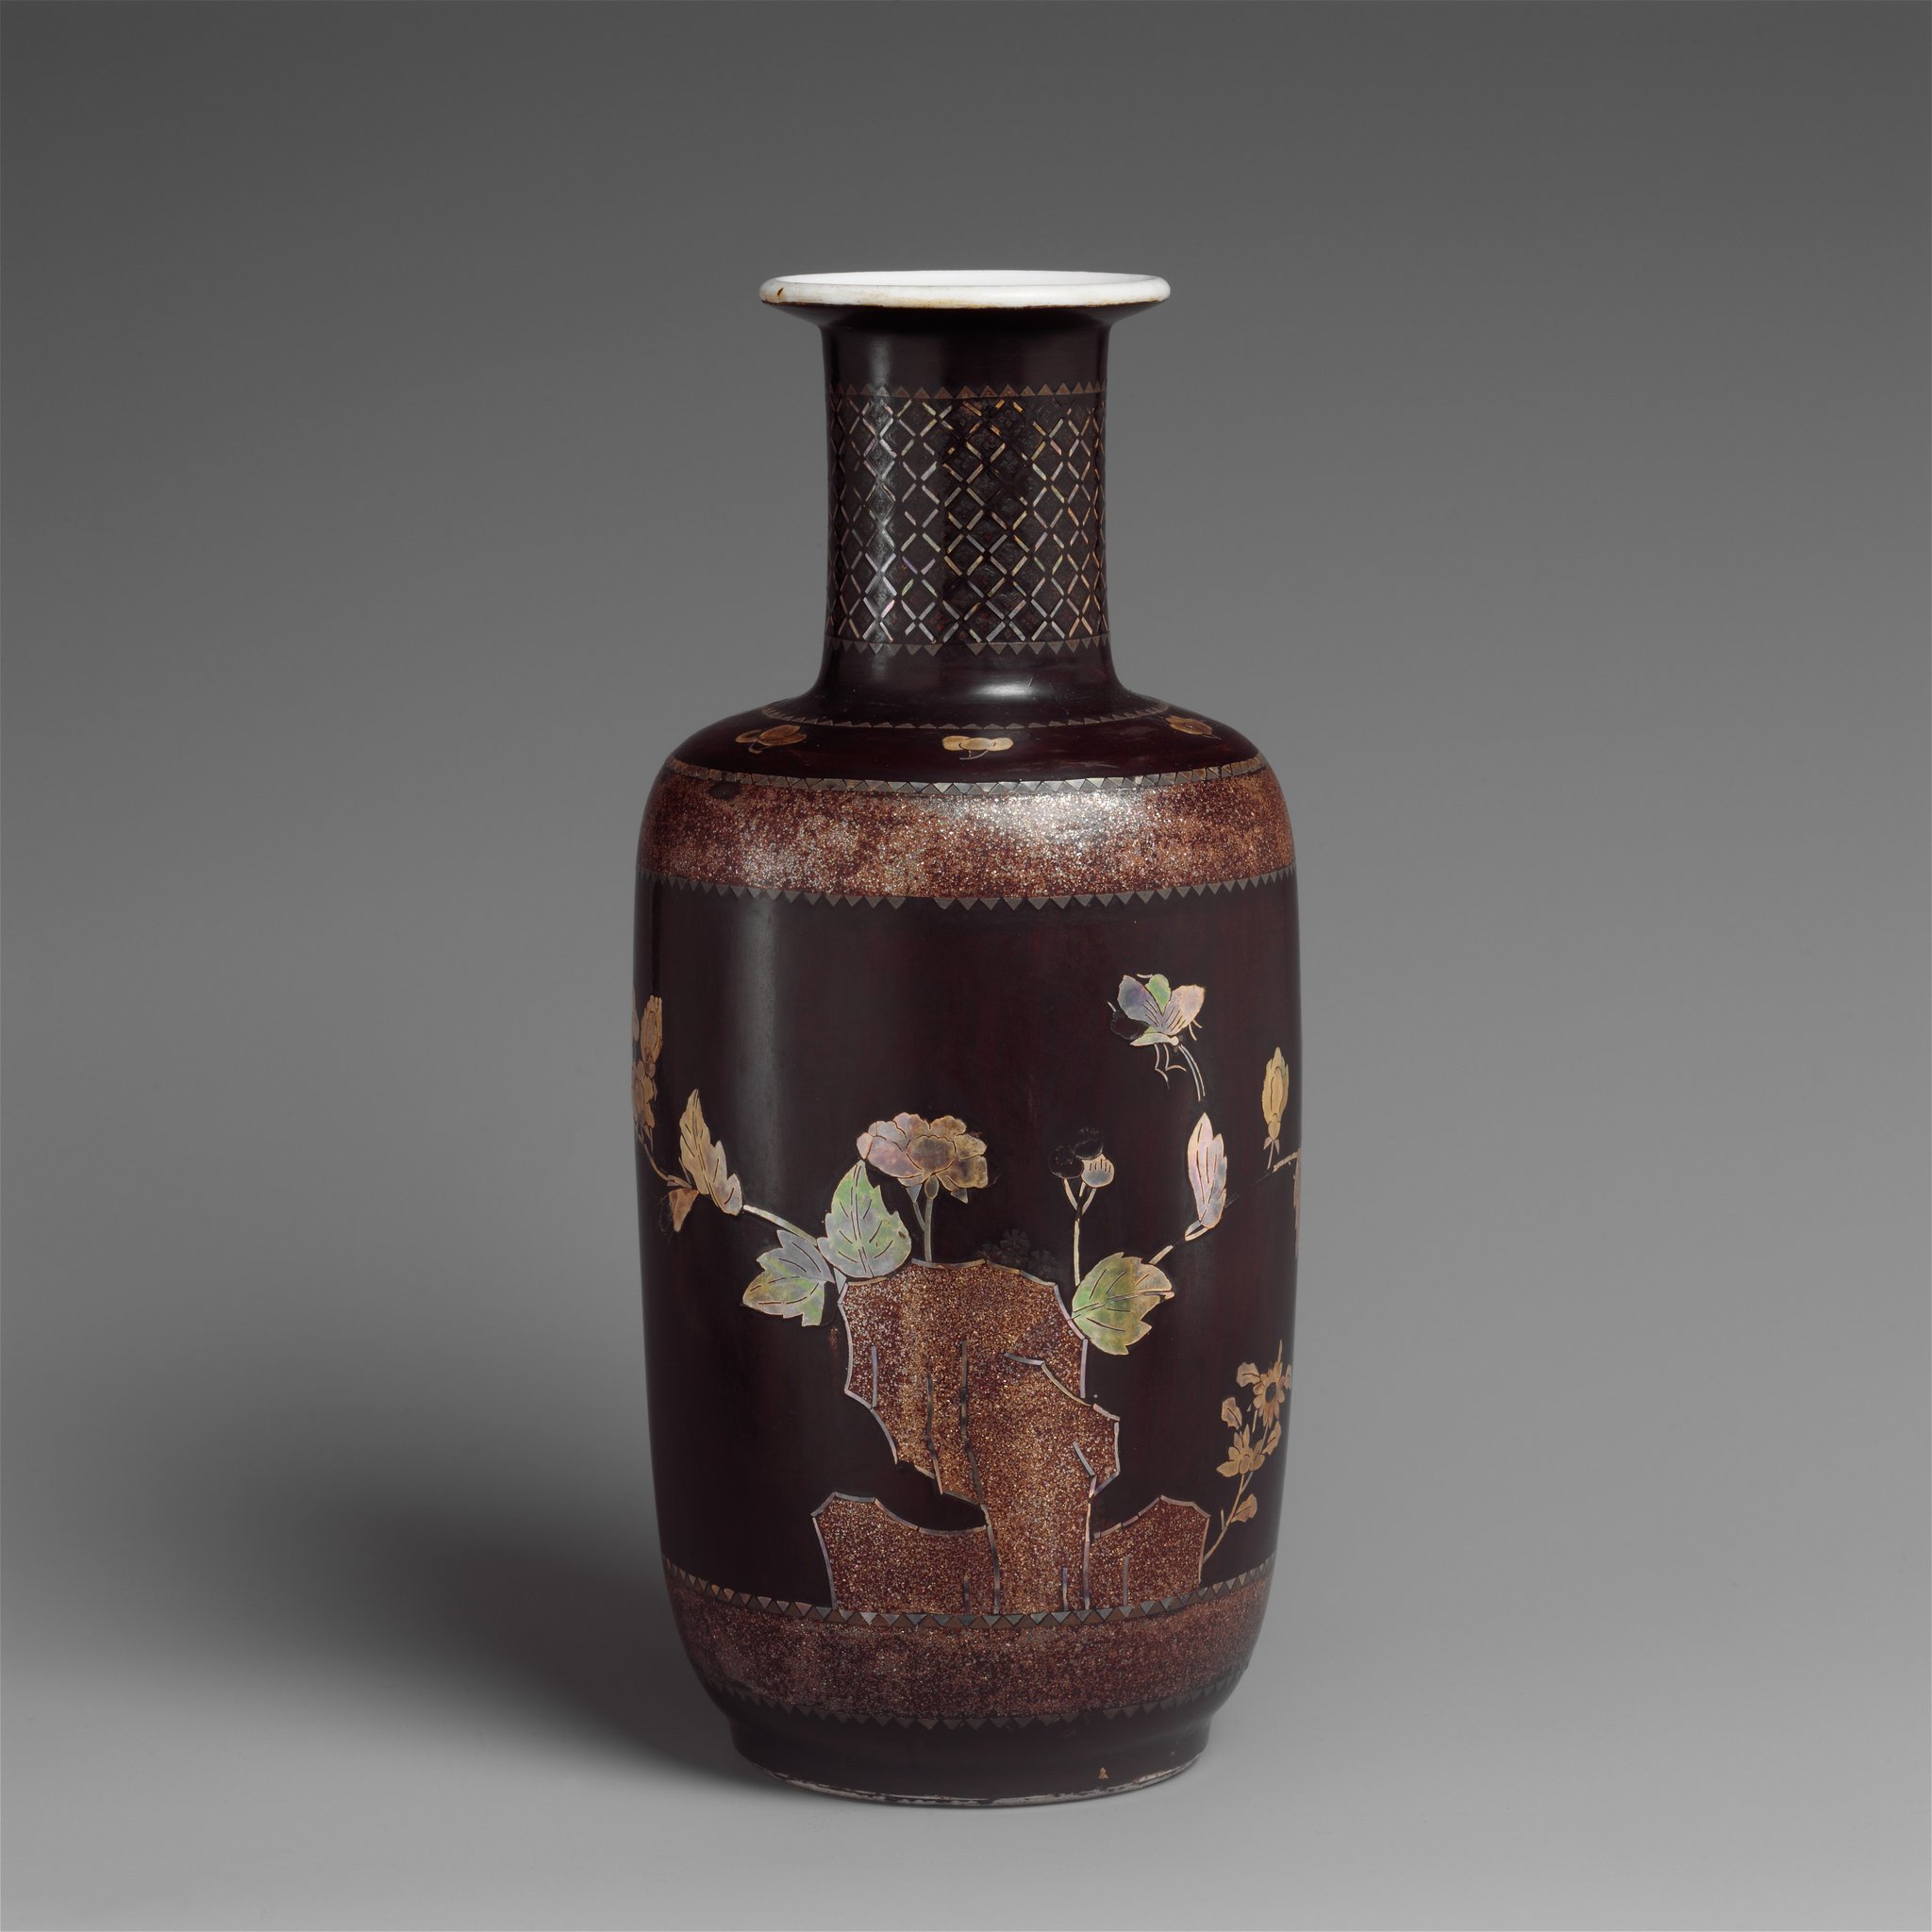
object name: vase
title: Vase with decoration of rocks, flowers, and butterflies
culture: chinese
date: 1662-1722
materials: lacquer, mother of pearl, porcelain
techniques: inlay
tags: butterflies,flowers